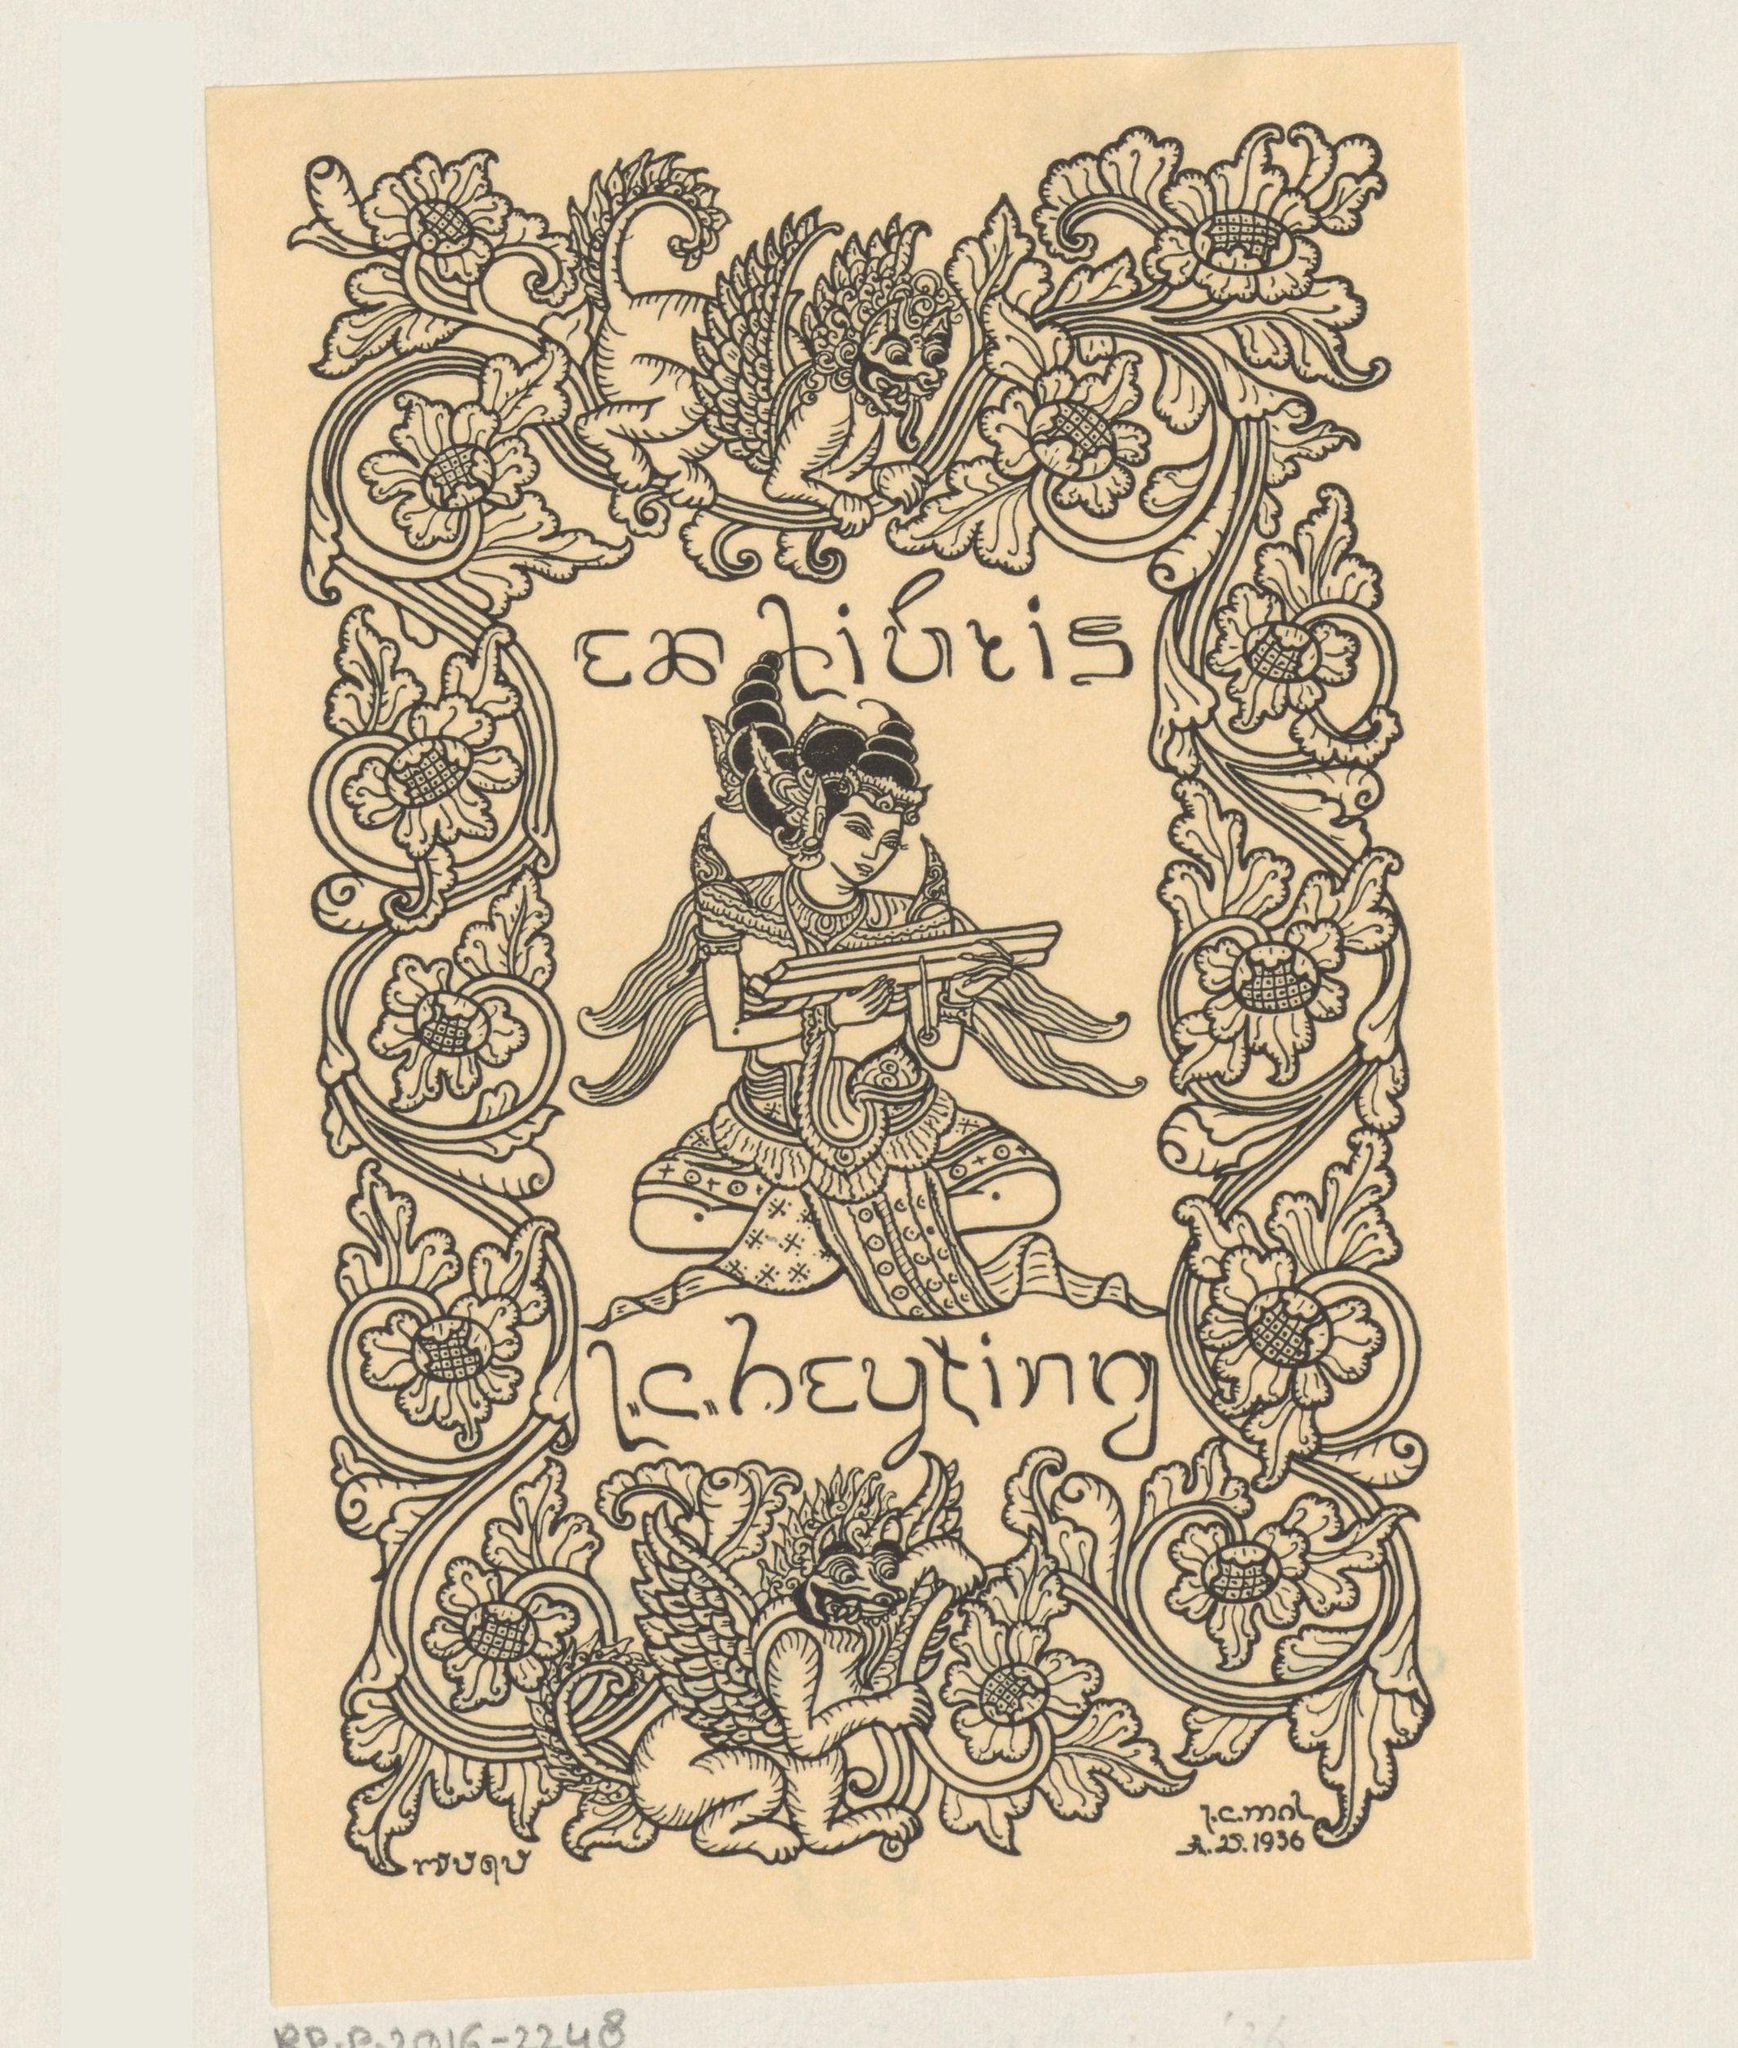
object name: bookplate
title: Ex libris van L.C. Heyting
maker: j.c. mol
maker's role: print maker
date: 1936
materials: paper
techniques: printing block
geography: netherlands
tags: l.c. heyting, adult woman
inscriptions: workshop stamp: ‘L.C. Heyting 's Hage / ontw. Mej. J.C. Mol, Wassenaar / cl’